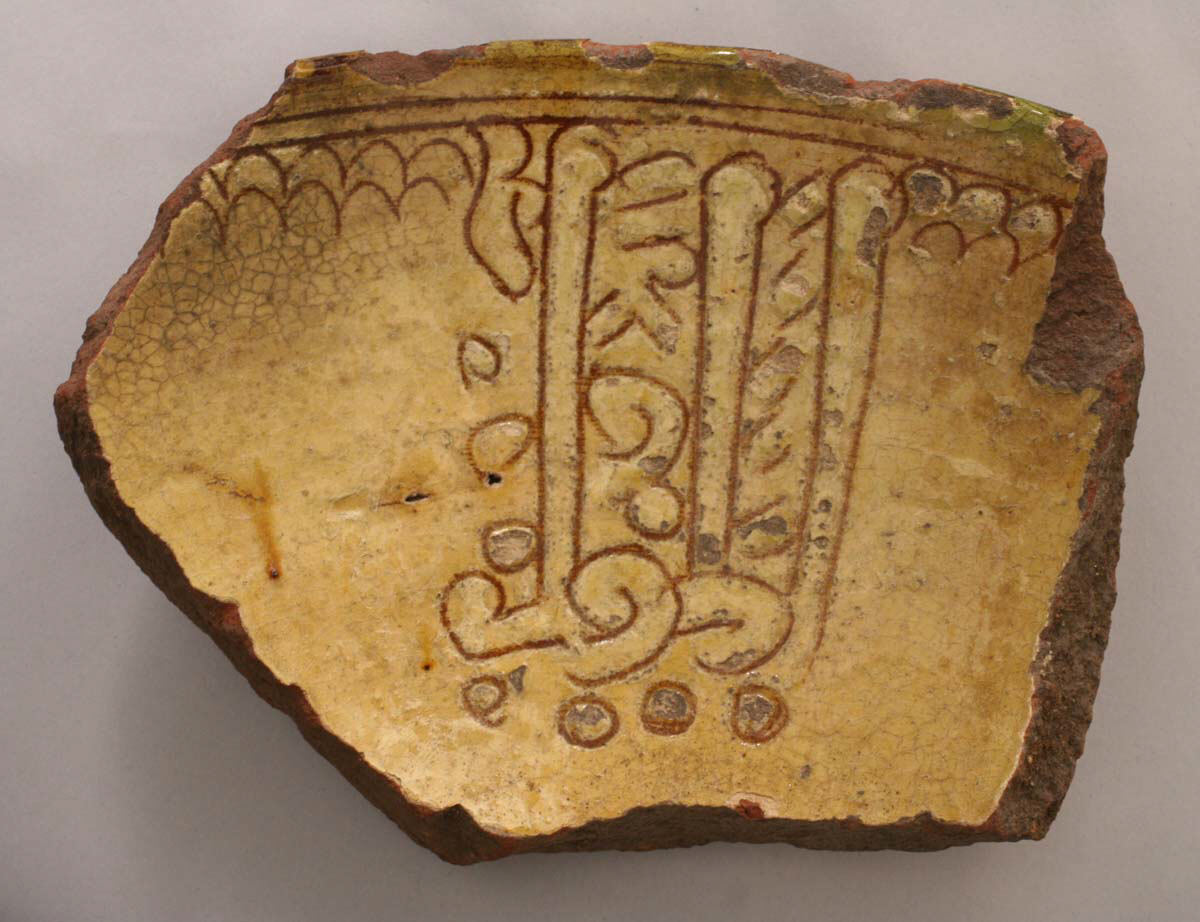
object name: fragment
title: Ceramic Fragment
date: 1301-1500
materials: earthenware, glaze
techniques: coloring, incising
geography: egypt